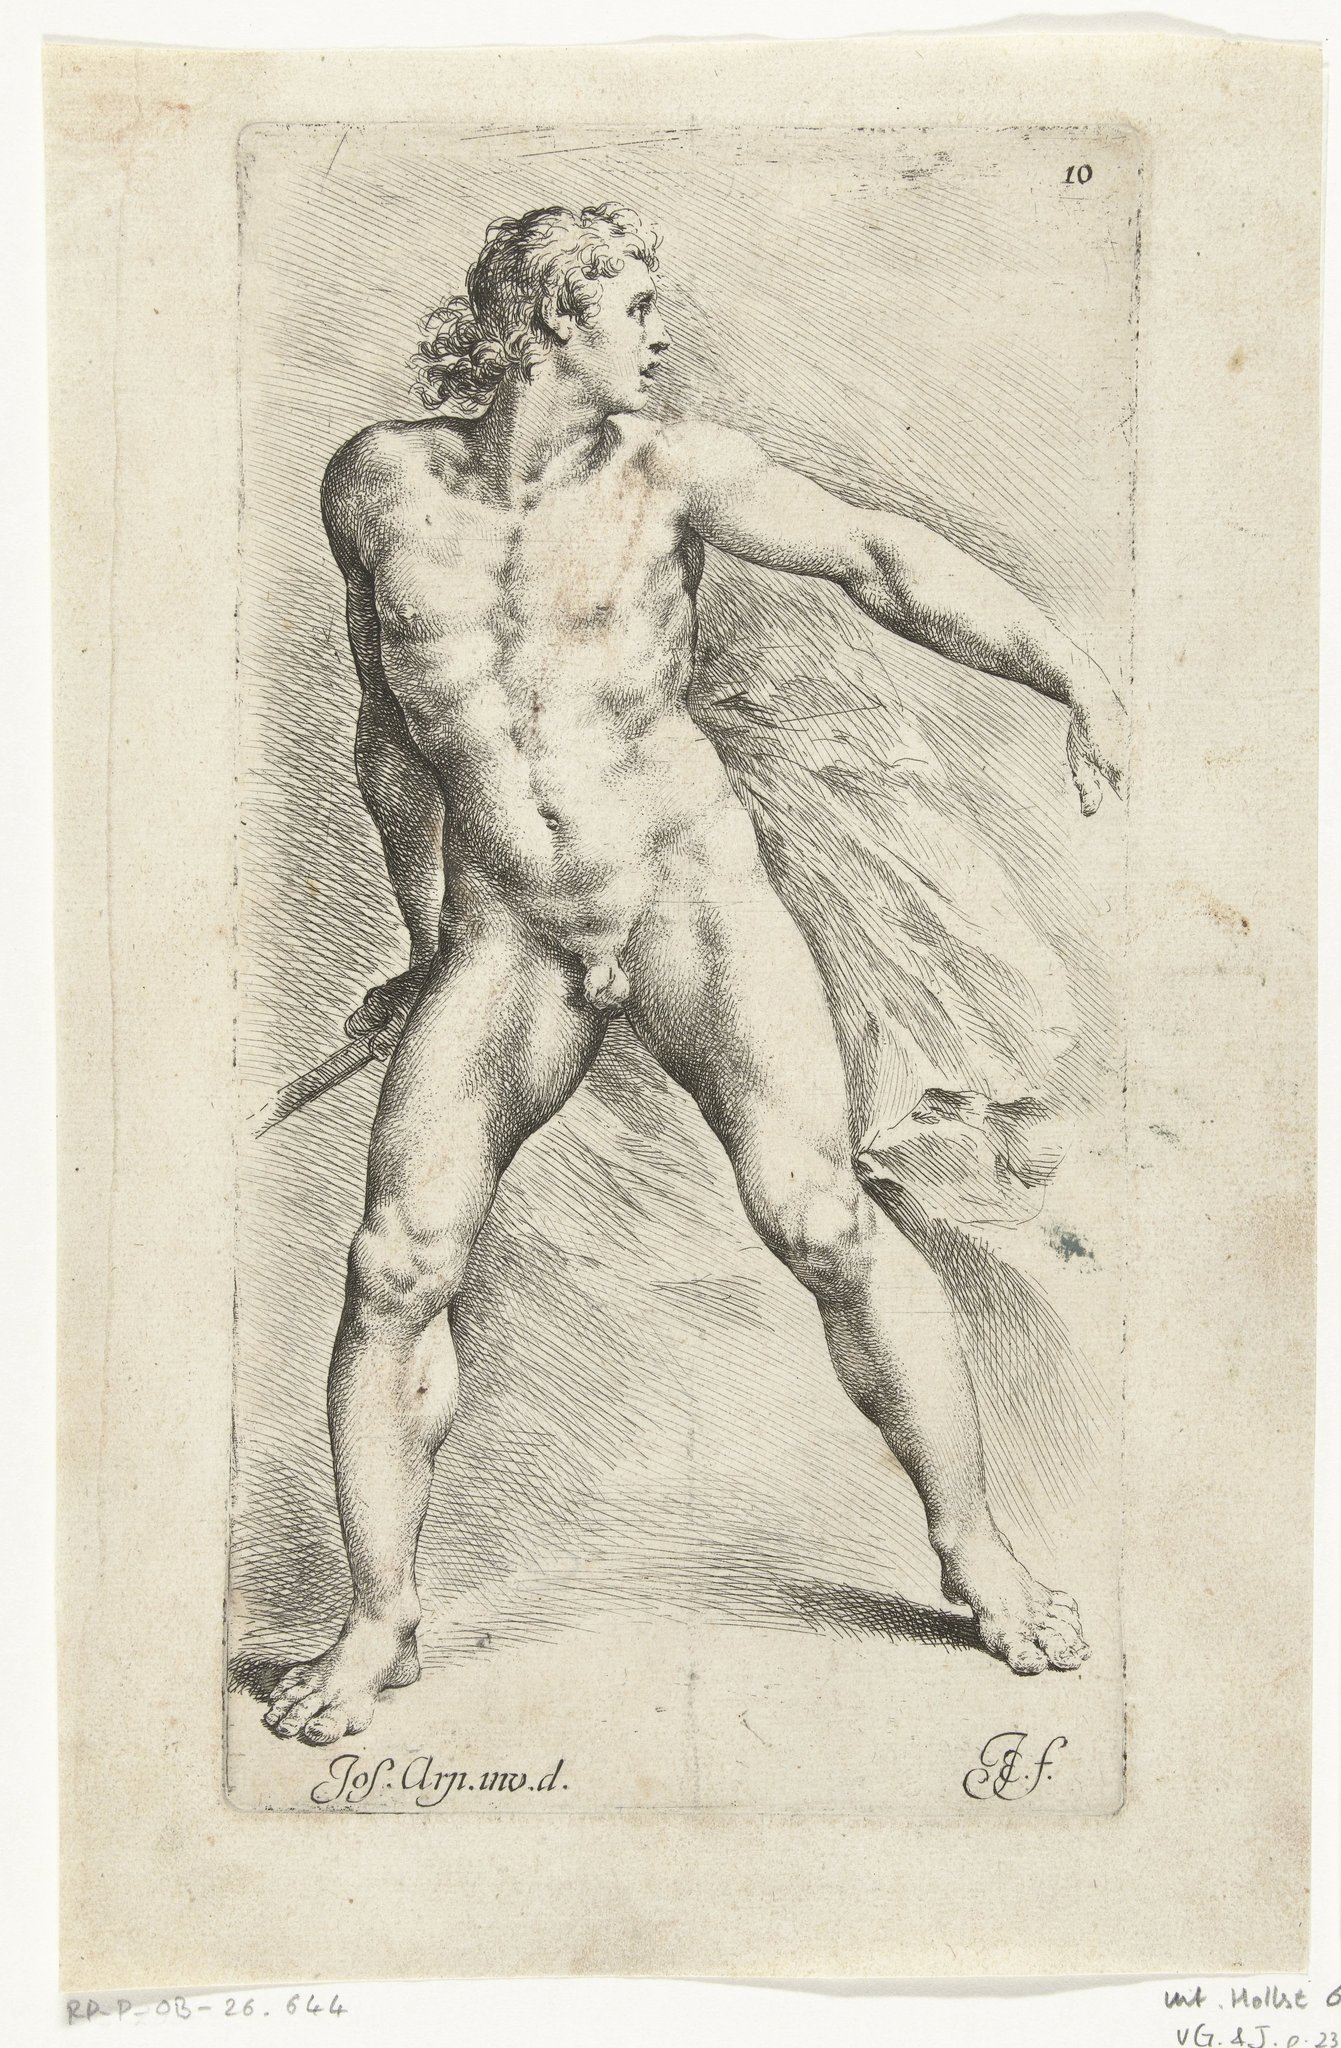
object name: print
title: Naakte man met een piek in zijn hand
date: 1668-1671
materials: paper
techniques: etching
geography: northern netherlands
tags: male sex; man (+ forward)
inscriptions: collector's mark: Lugt 2228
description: afkomstig uit: Paradigmata graphices variorum artificum : voor-beelden der teken-konst van verscheyde meesters, Hagae-Comitis, 1671.